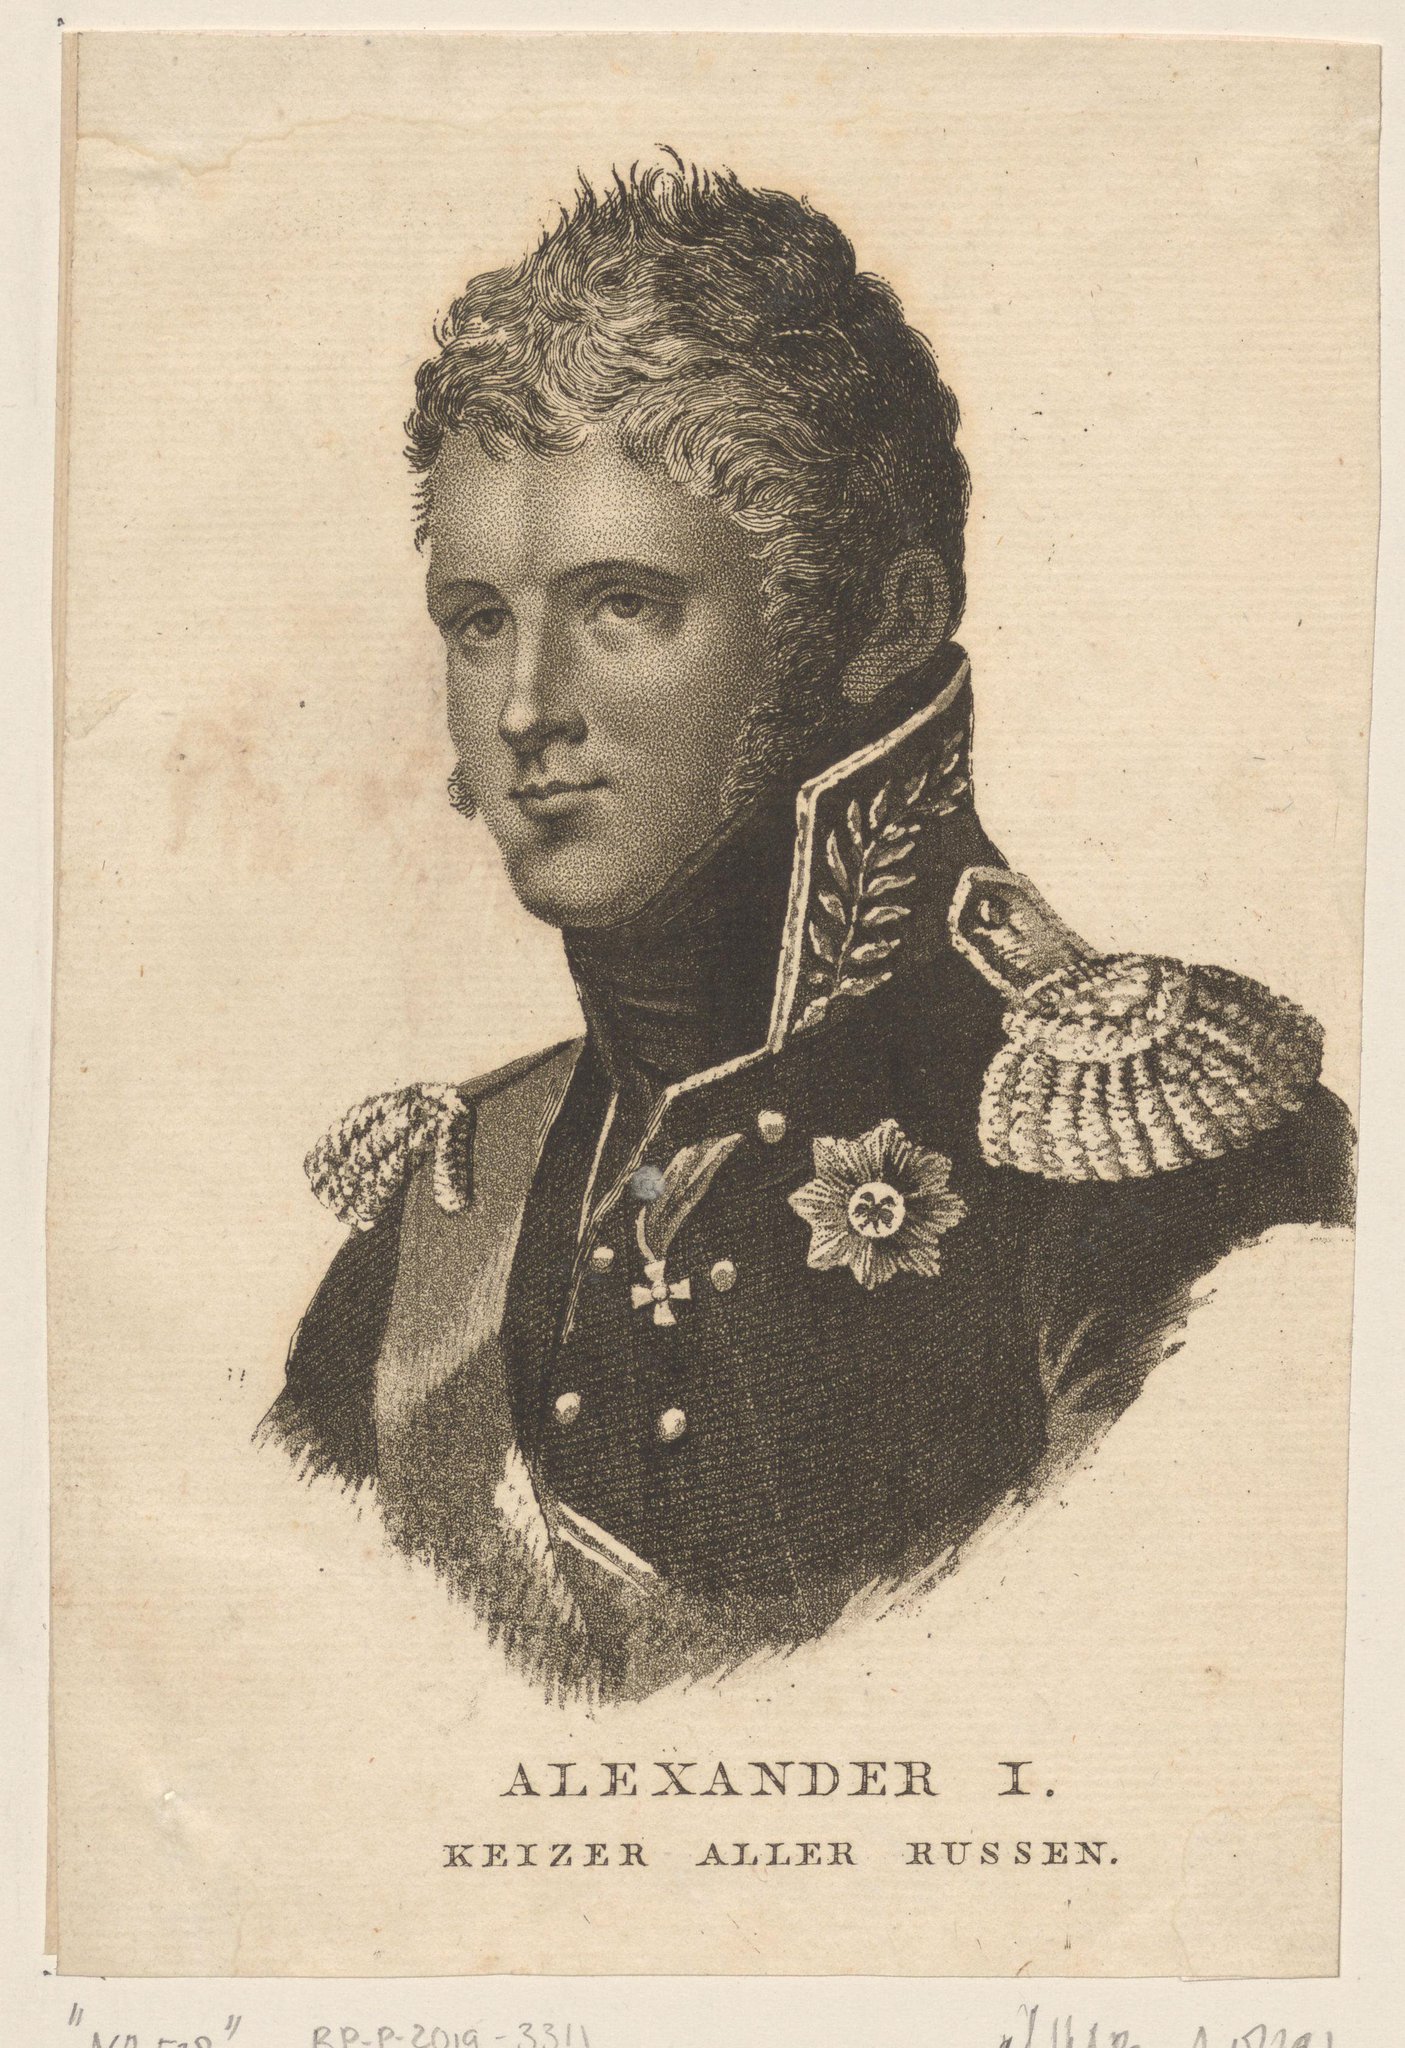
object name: print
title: Portret van Alexander I, tsaar van Rusland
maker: Anonymous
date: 1801-1850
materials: paper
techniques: aquatint, etching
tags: alexander i (tsaar van rusland), historical persons, emperor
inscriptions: collector's mark: Lugt 2228